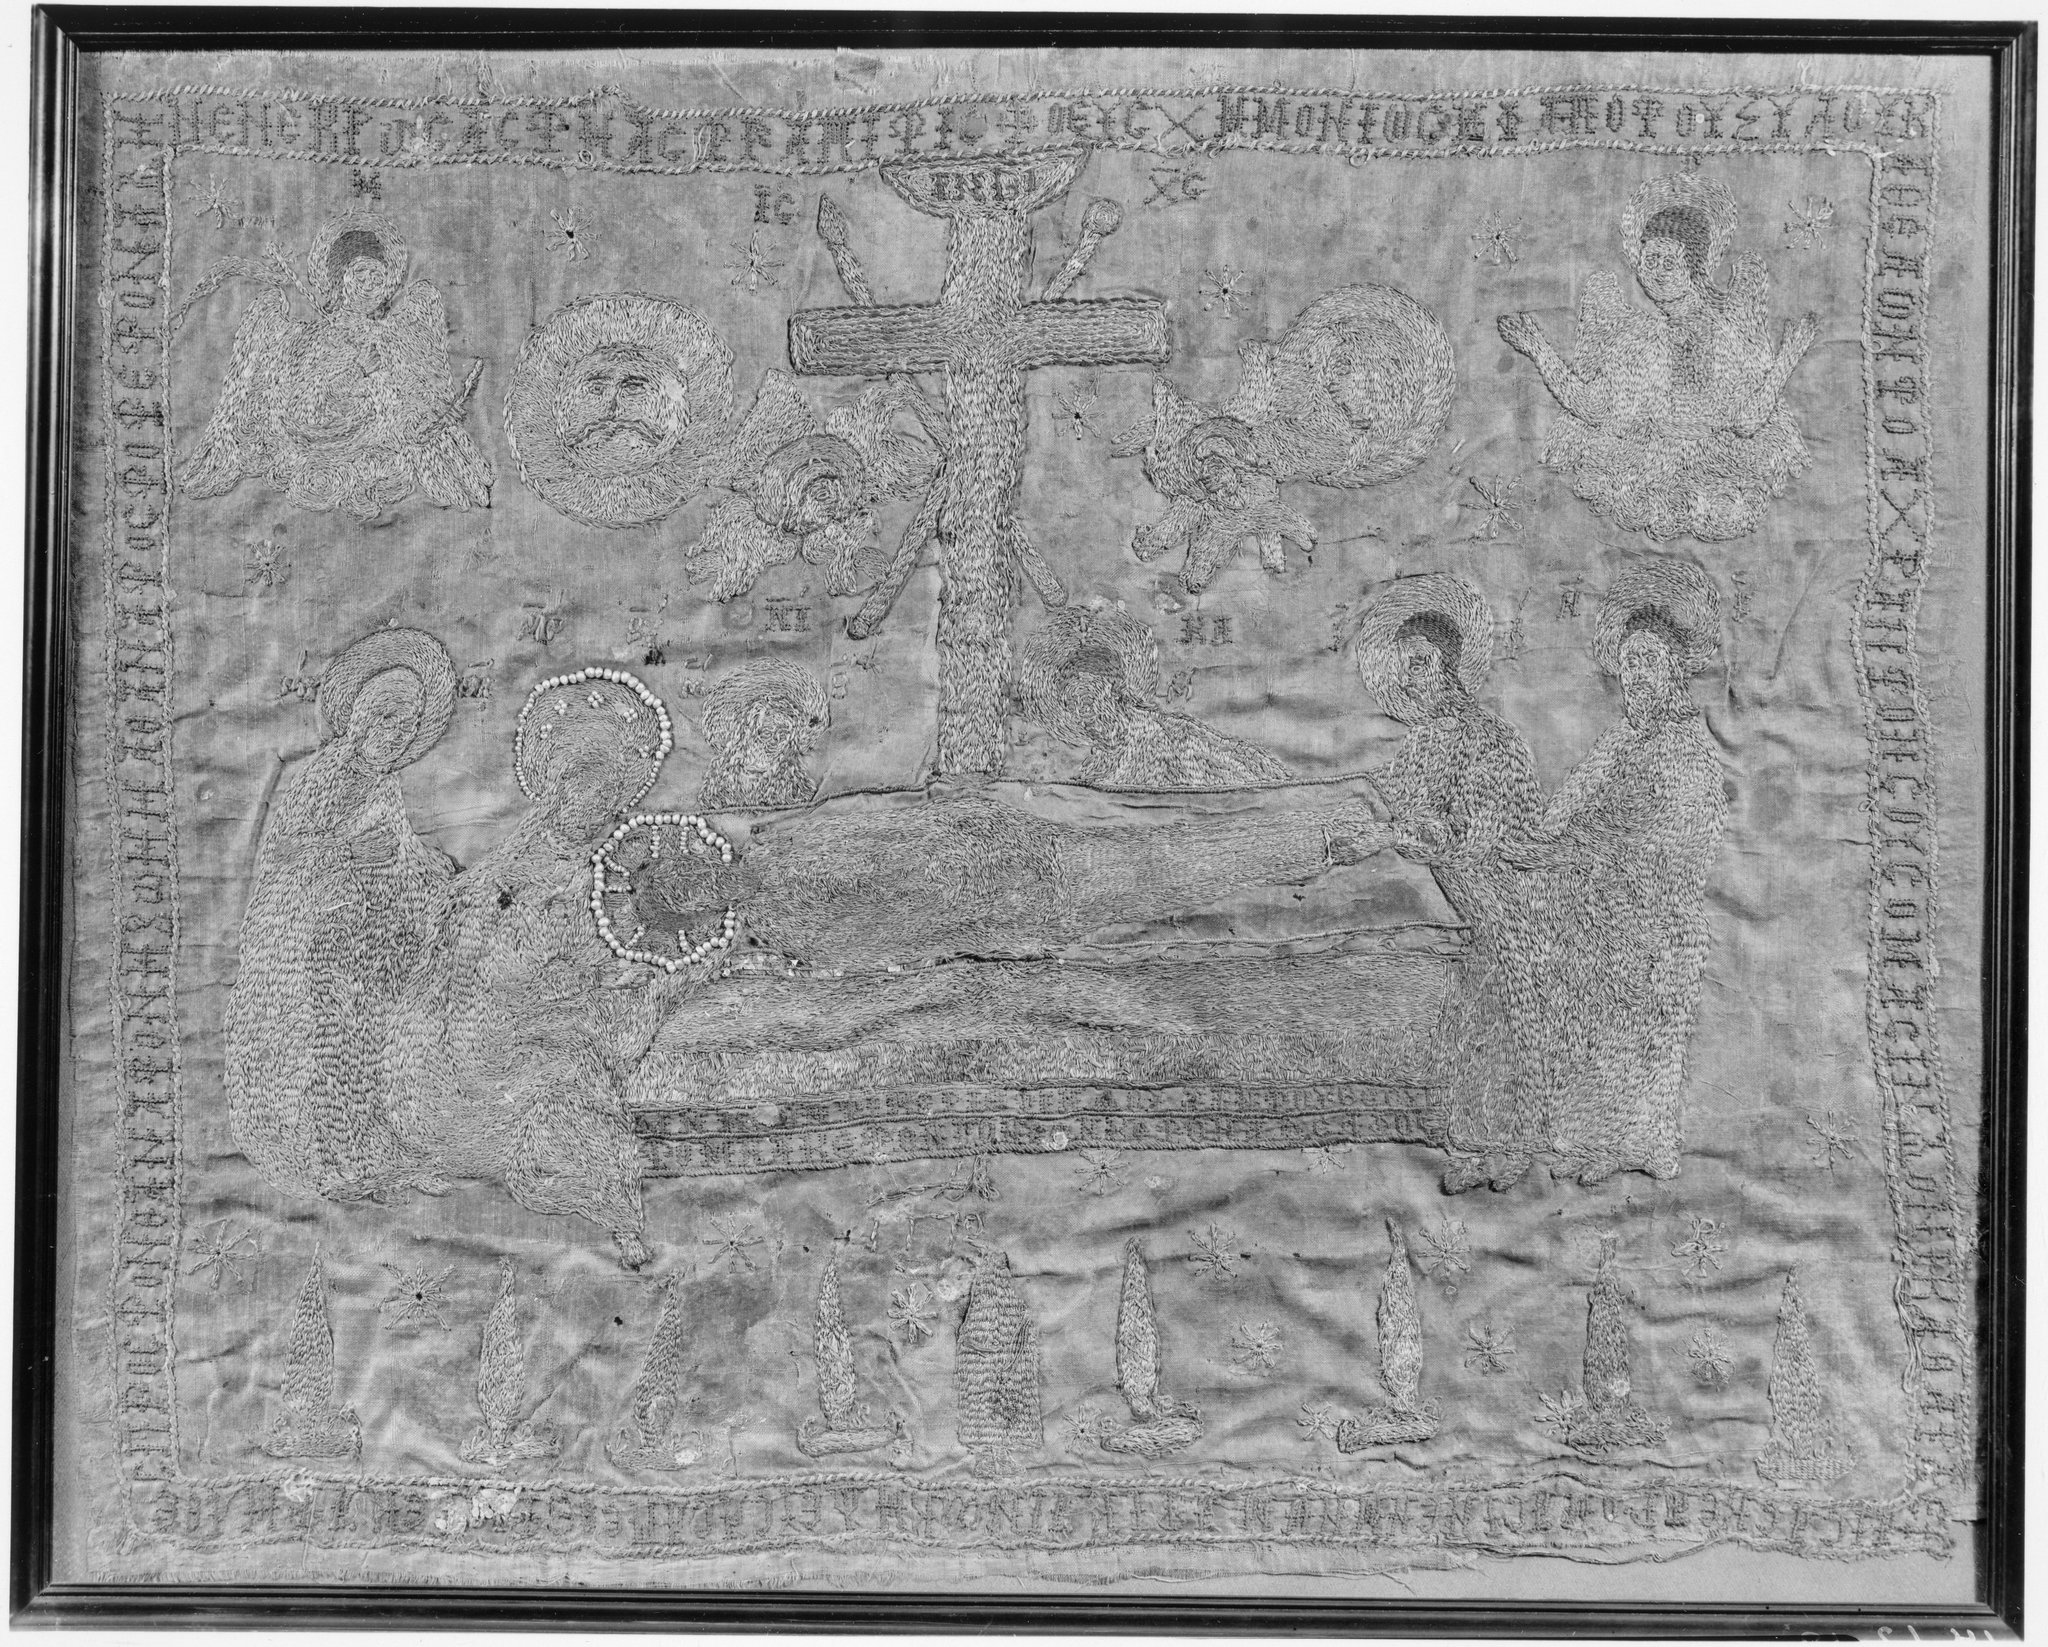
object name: epitaphios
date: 1772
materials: linen, metal thread, silk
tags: angels,cross,jesus